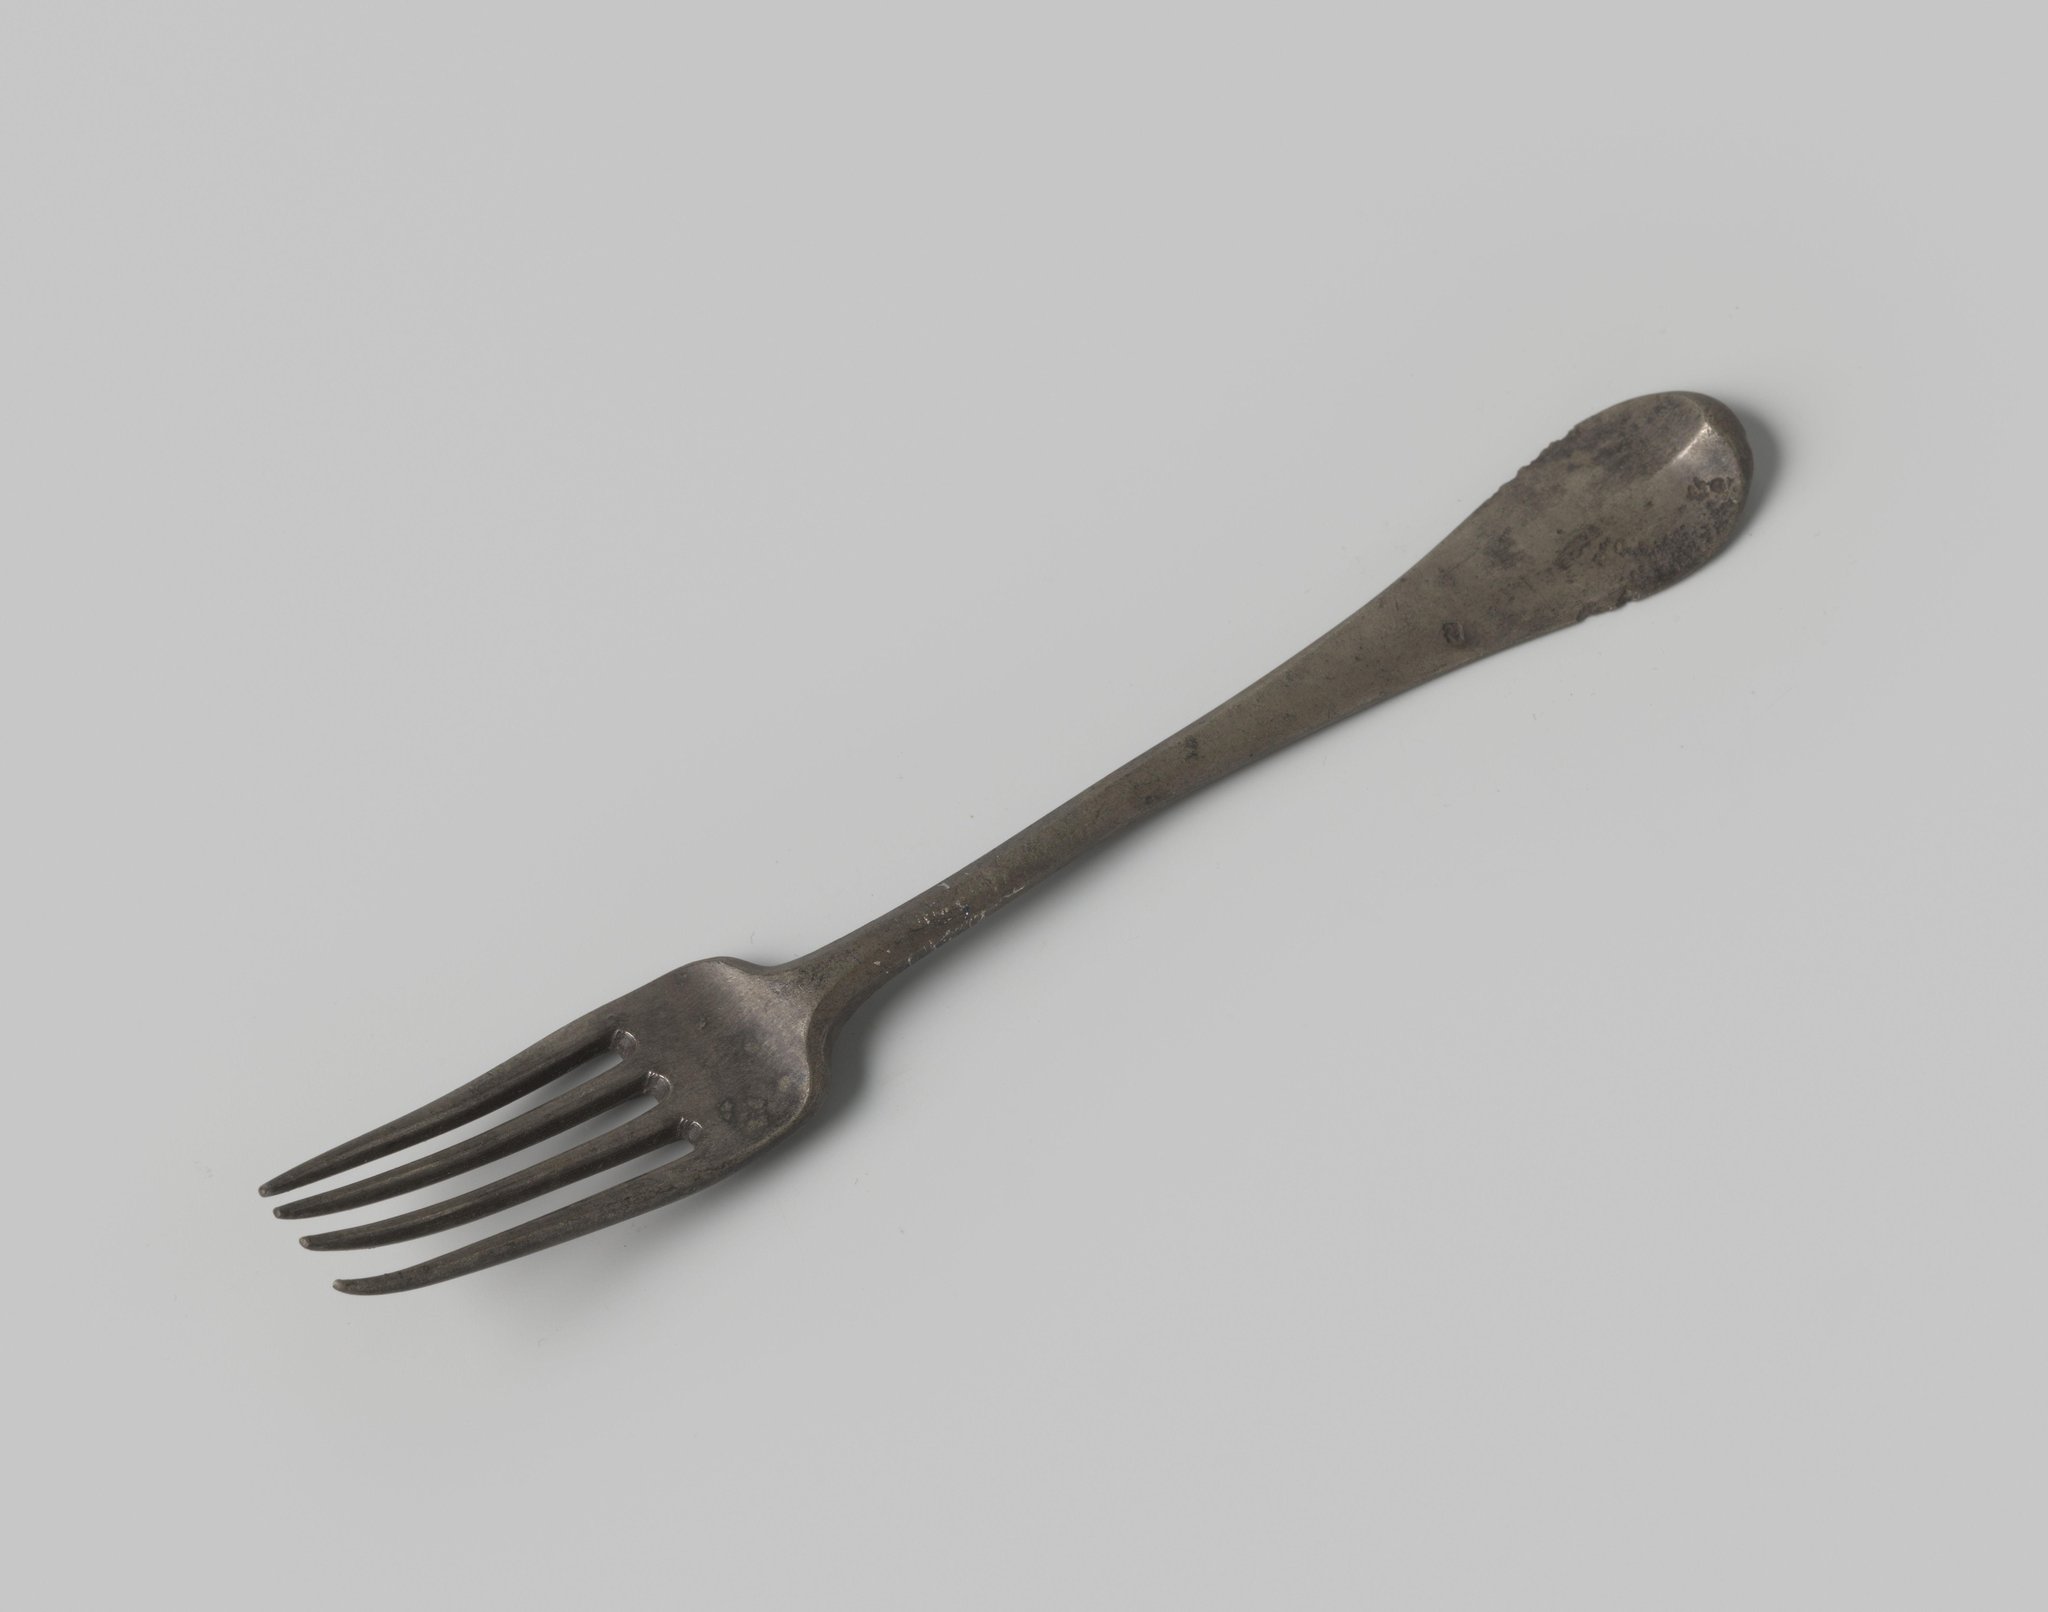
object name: fork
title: Vork uit het wrak van de Oost-Indiëvaarder 't Vliegend Hart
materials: tin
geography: middelburg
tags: 't vliegend hart (schip), verenigde oostindische compagnie